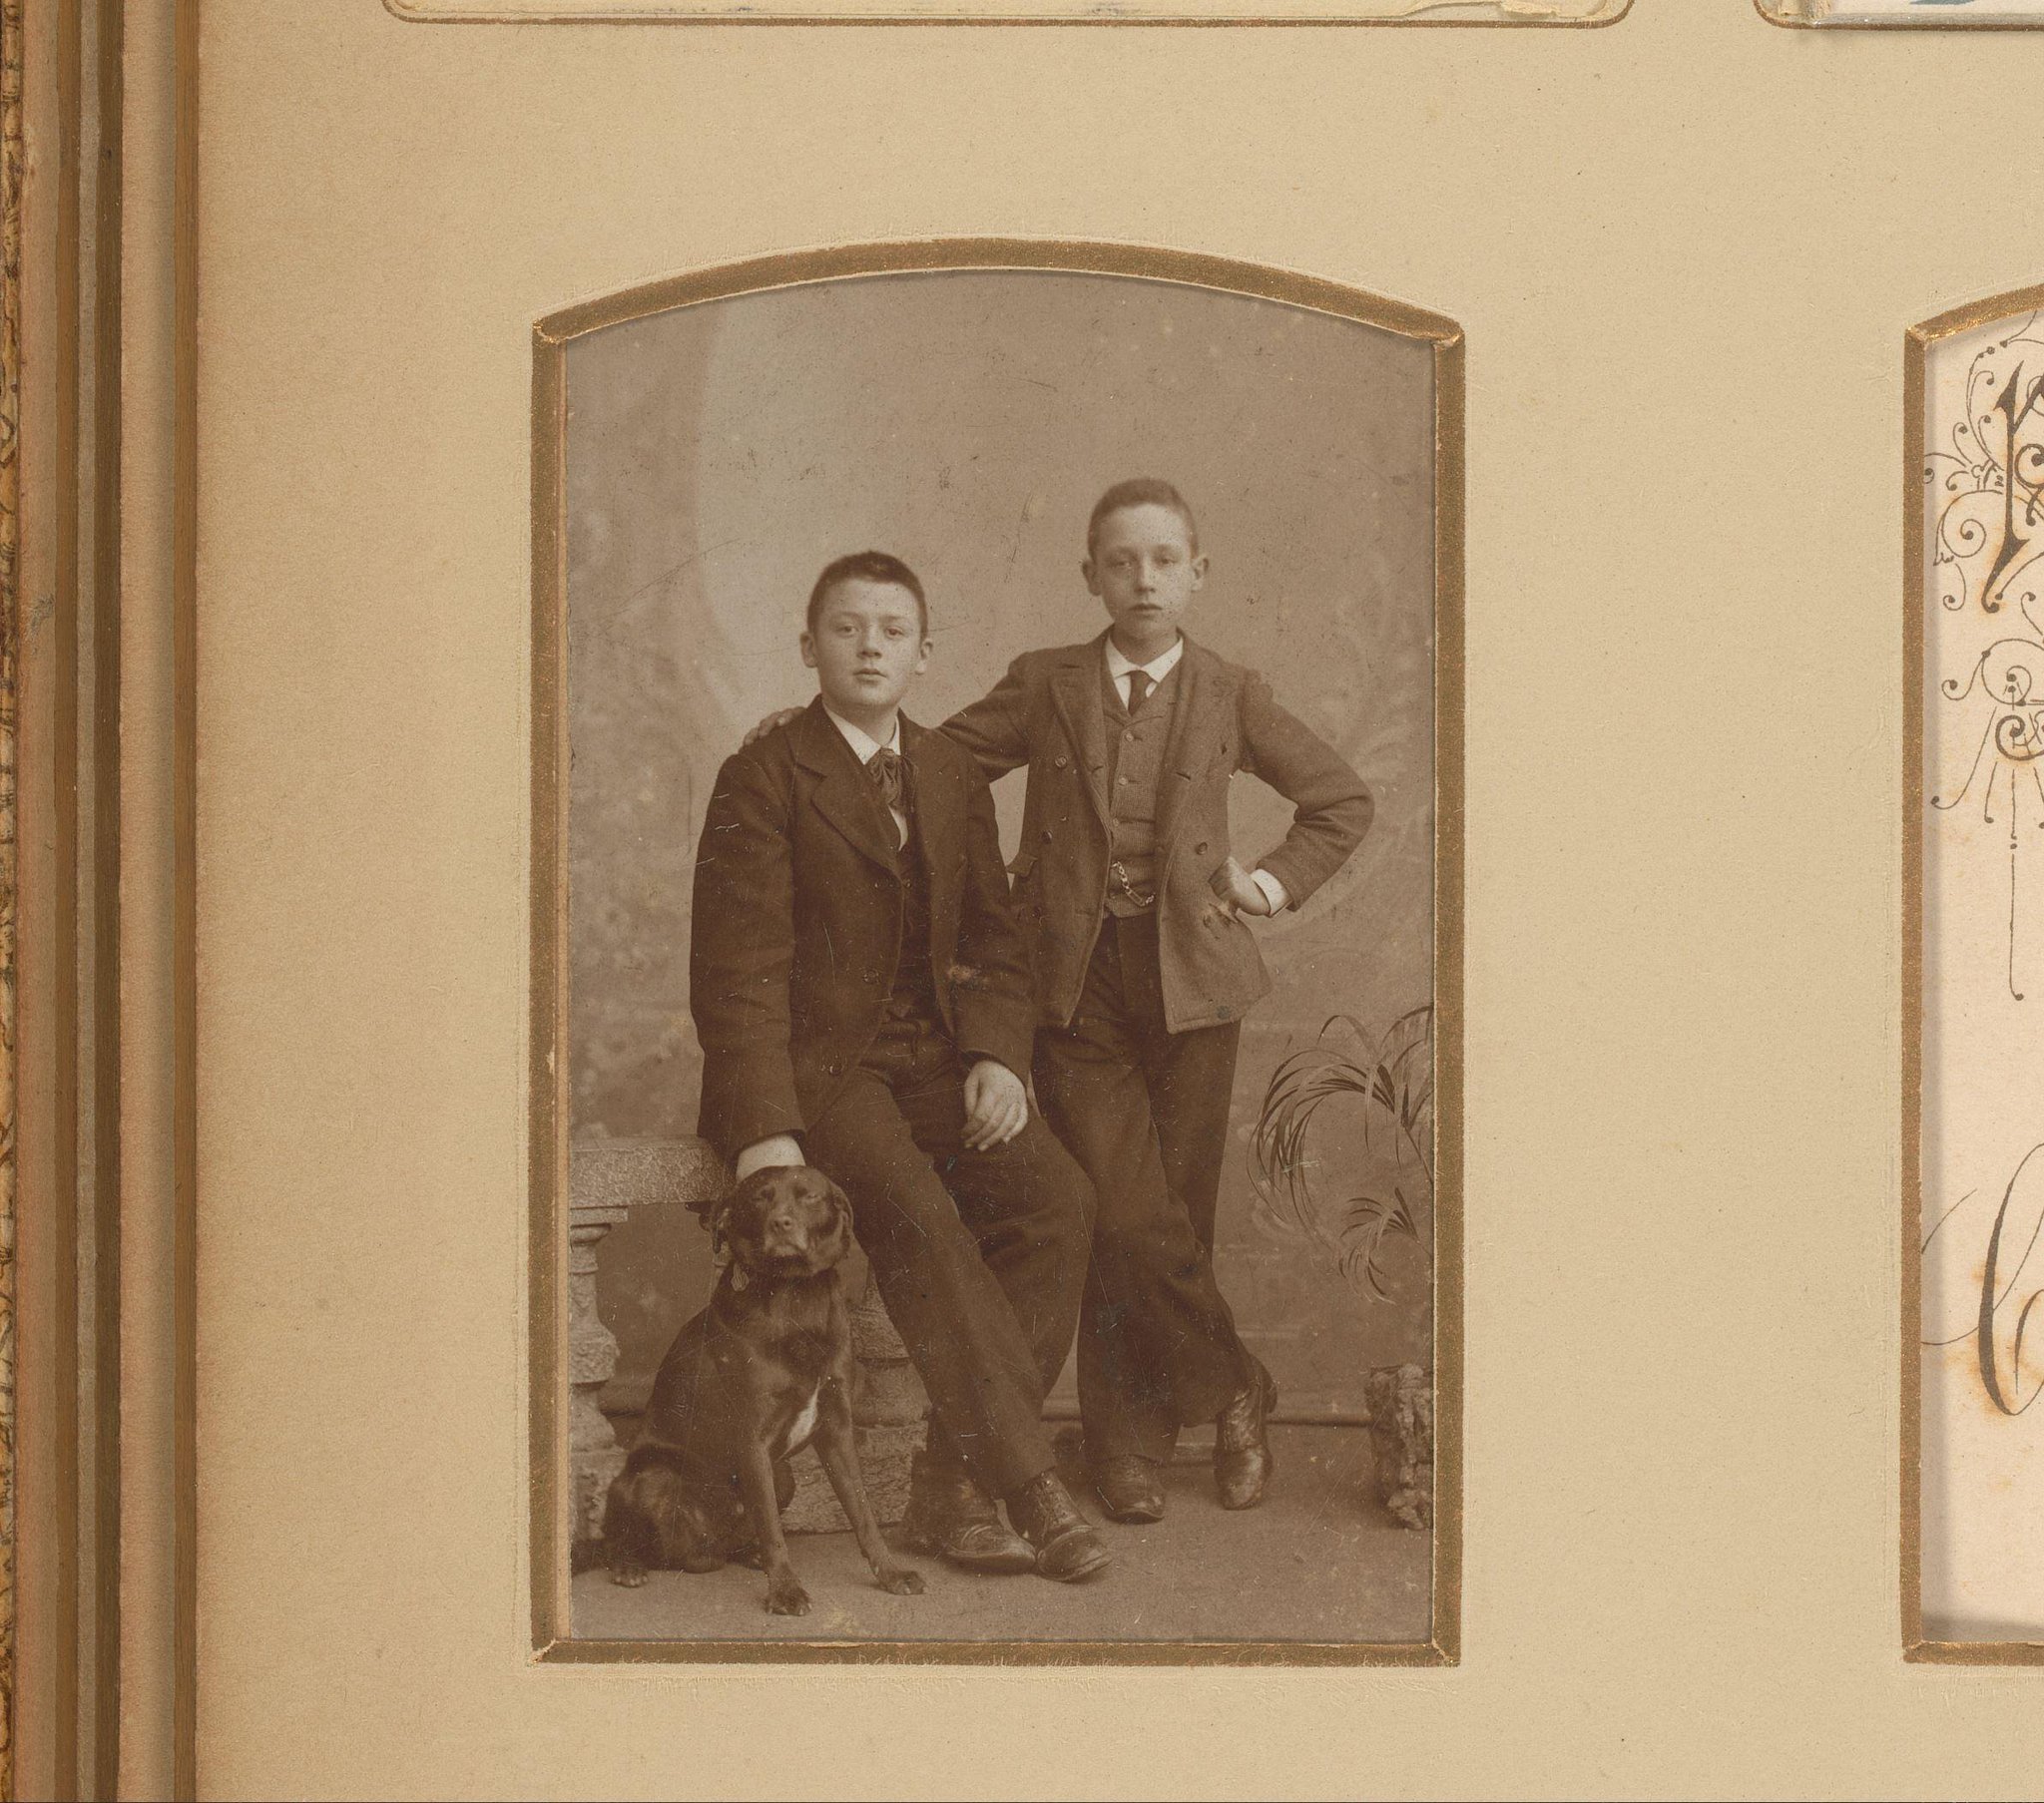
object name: photograph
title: Portret van twee jongens en een hond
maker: willem carel heijenberg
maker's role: fotograaf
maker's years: 1835-1895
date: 1882-1895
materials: cardboard, photographic support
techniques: collodion silver print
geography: utrecht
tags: boy (child between toddler and youth) (+ two persons), historical persons, dog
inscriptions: inscription: ‘W.C. Heijenberg/ PHOTOGRAPHE/ Nachtegaalstraat/ No 40/ Utrecht.’